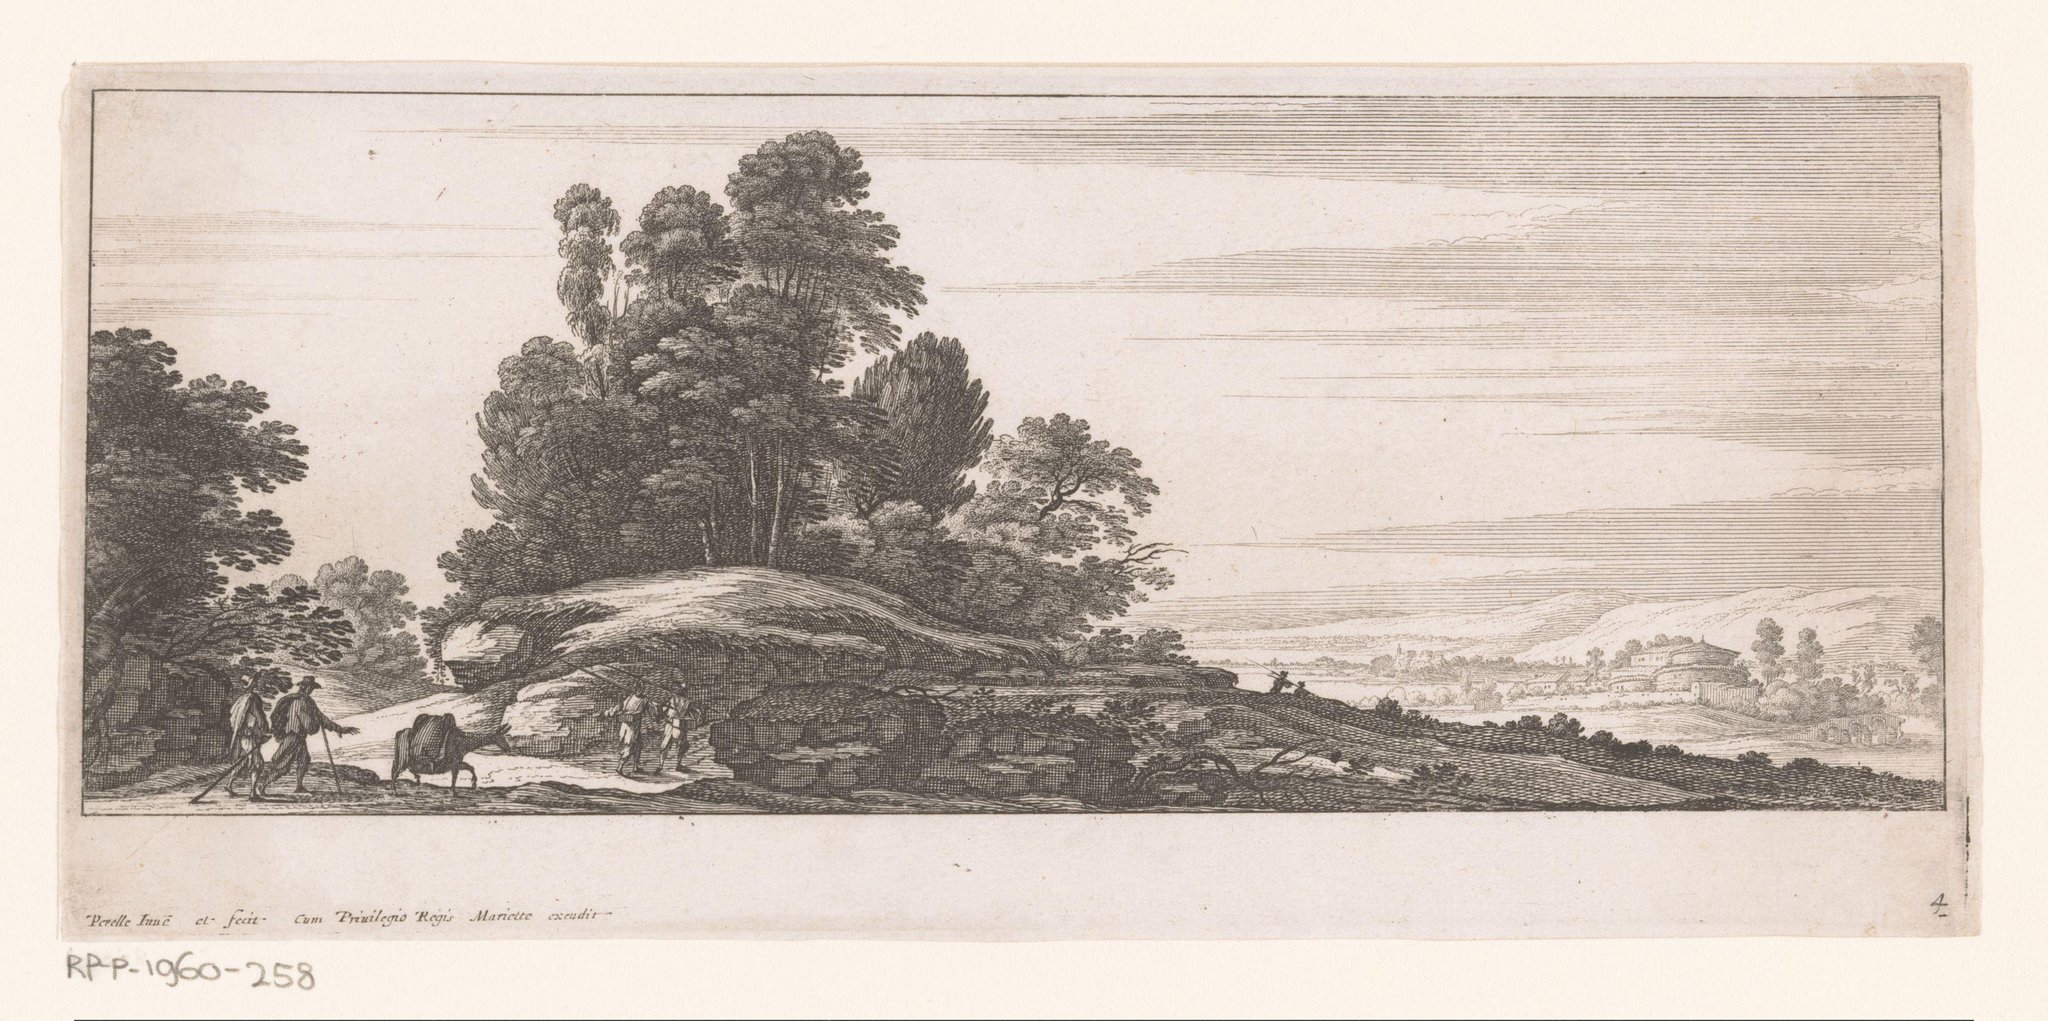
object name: print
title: Landschap met figuren en ezel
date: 1613-1657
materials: paper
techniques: etching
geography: paris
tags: landscapes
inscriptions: collector's mark: Lugt 2228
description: Prenten met het signatuur 'Perelle' kunnen zowel door vader Gabriel als door zonen Nicolas en Adam gemaakt zijn.